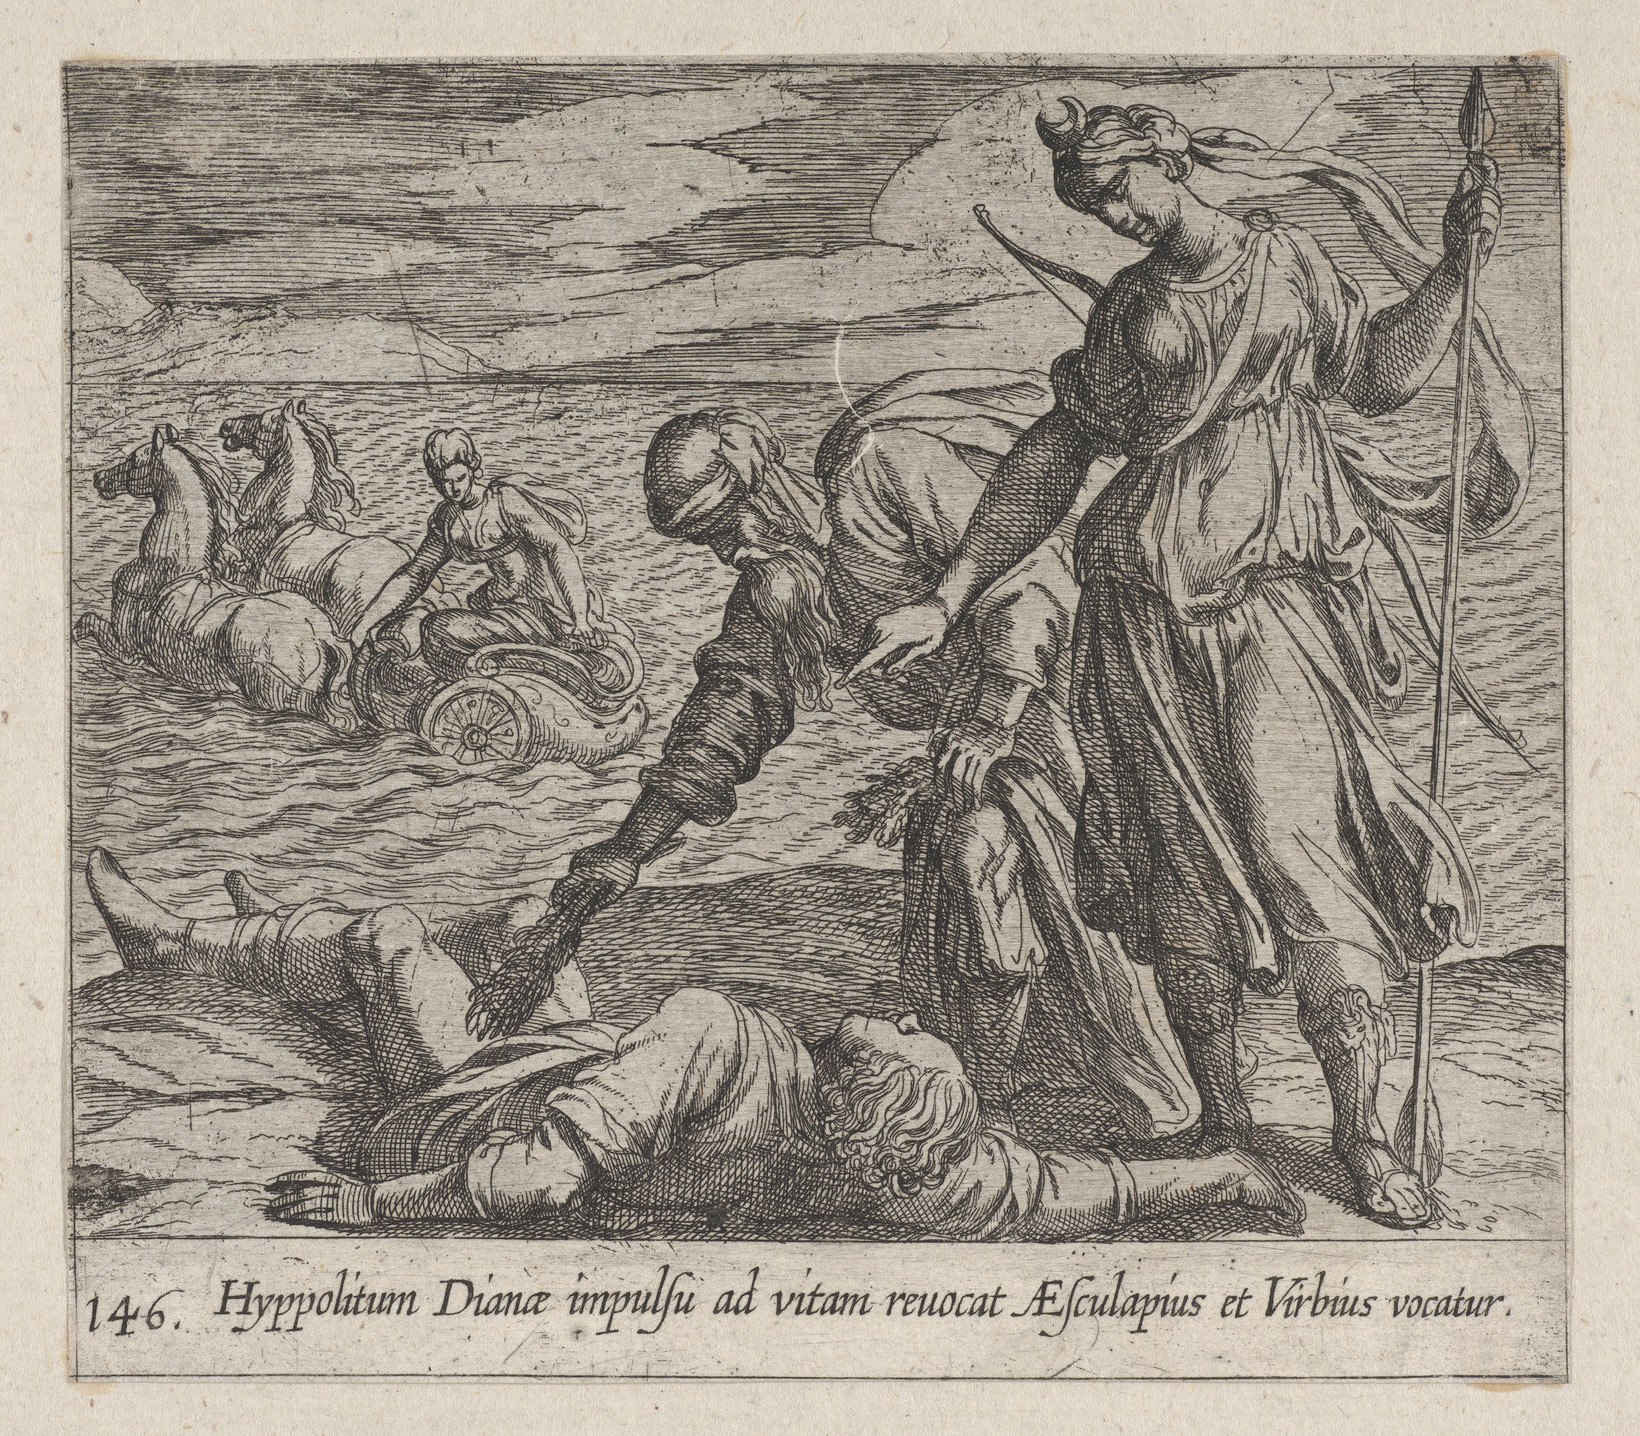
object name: print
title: Plate 146: Hippolytus Saved from Death (Hippolitum Dianae impulsu ad vitam revocat AEsculapius et Virbius vocatur), from Ovid's 'Metamorphoses'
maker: antonio tempesta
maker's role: artist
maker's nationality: italian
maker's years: 1555-1630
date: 1606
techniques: etching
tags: men,women,horses,chariots